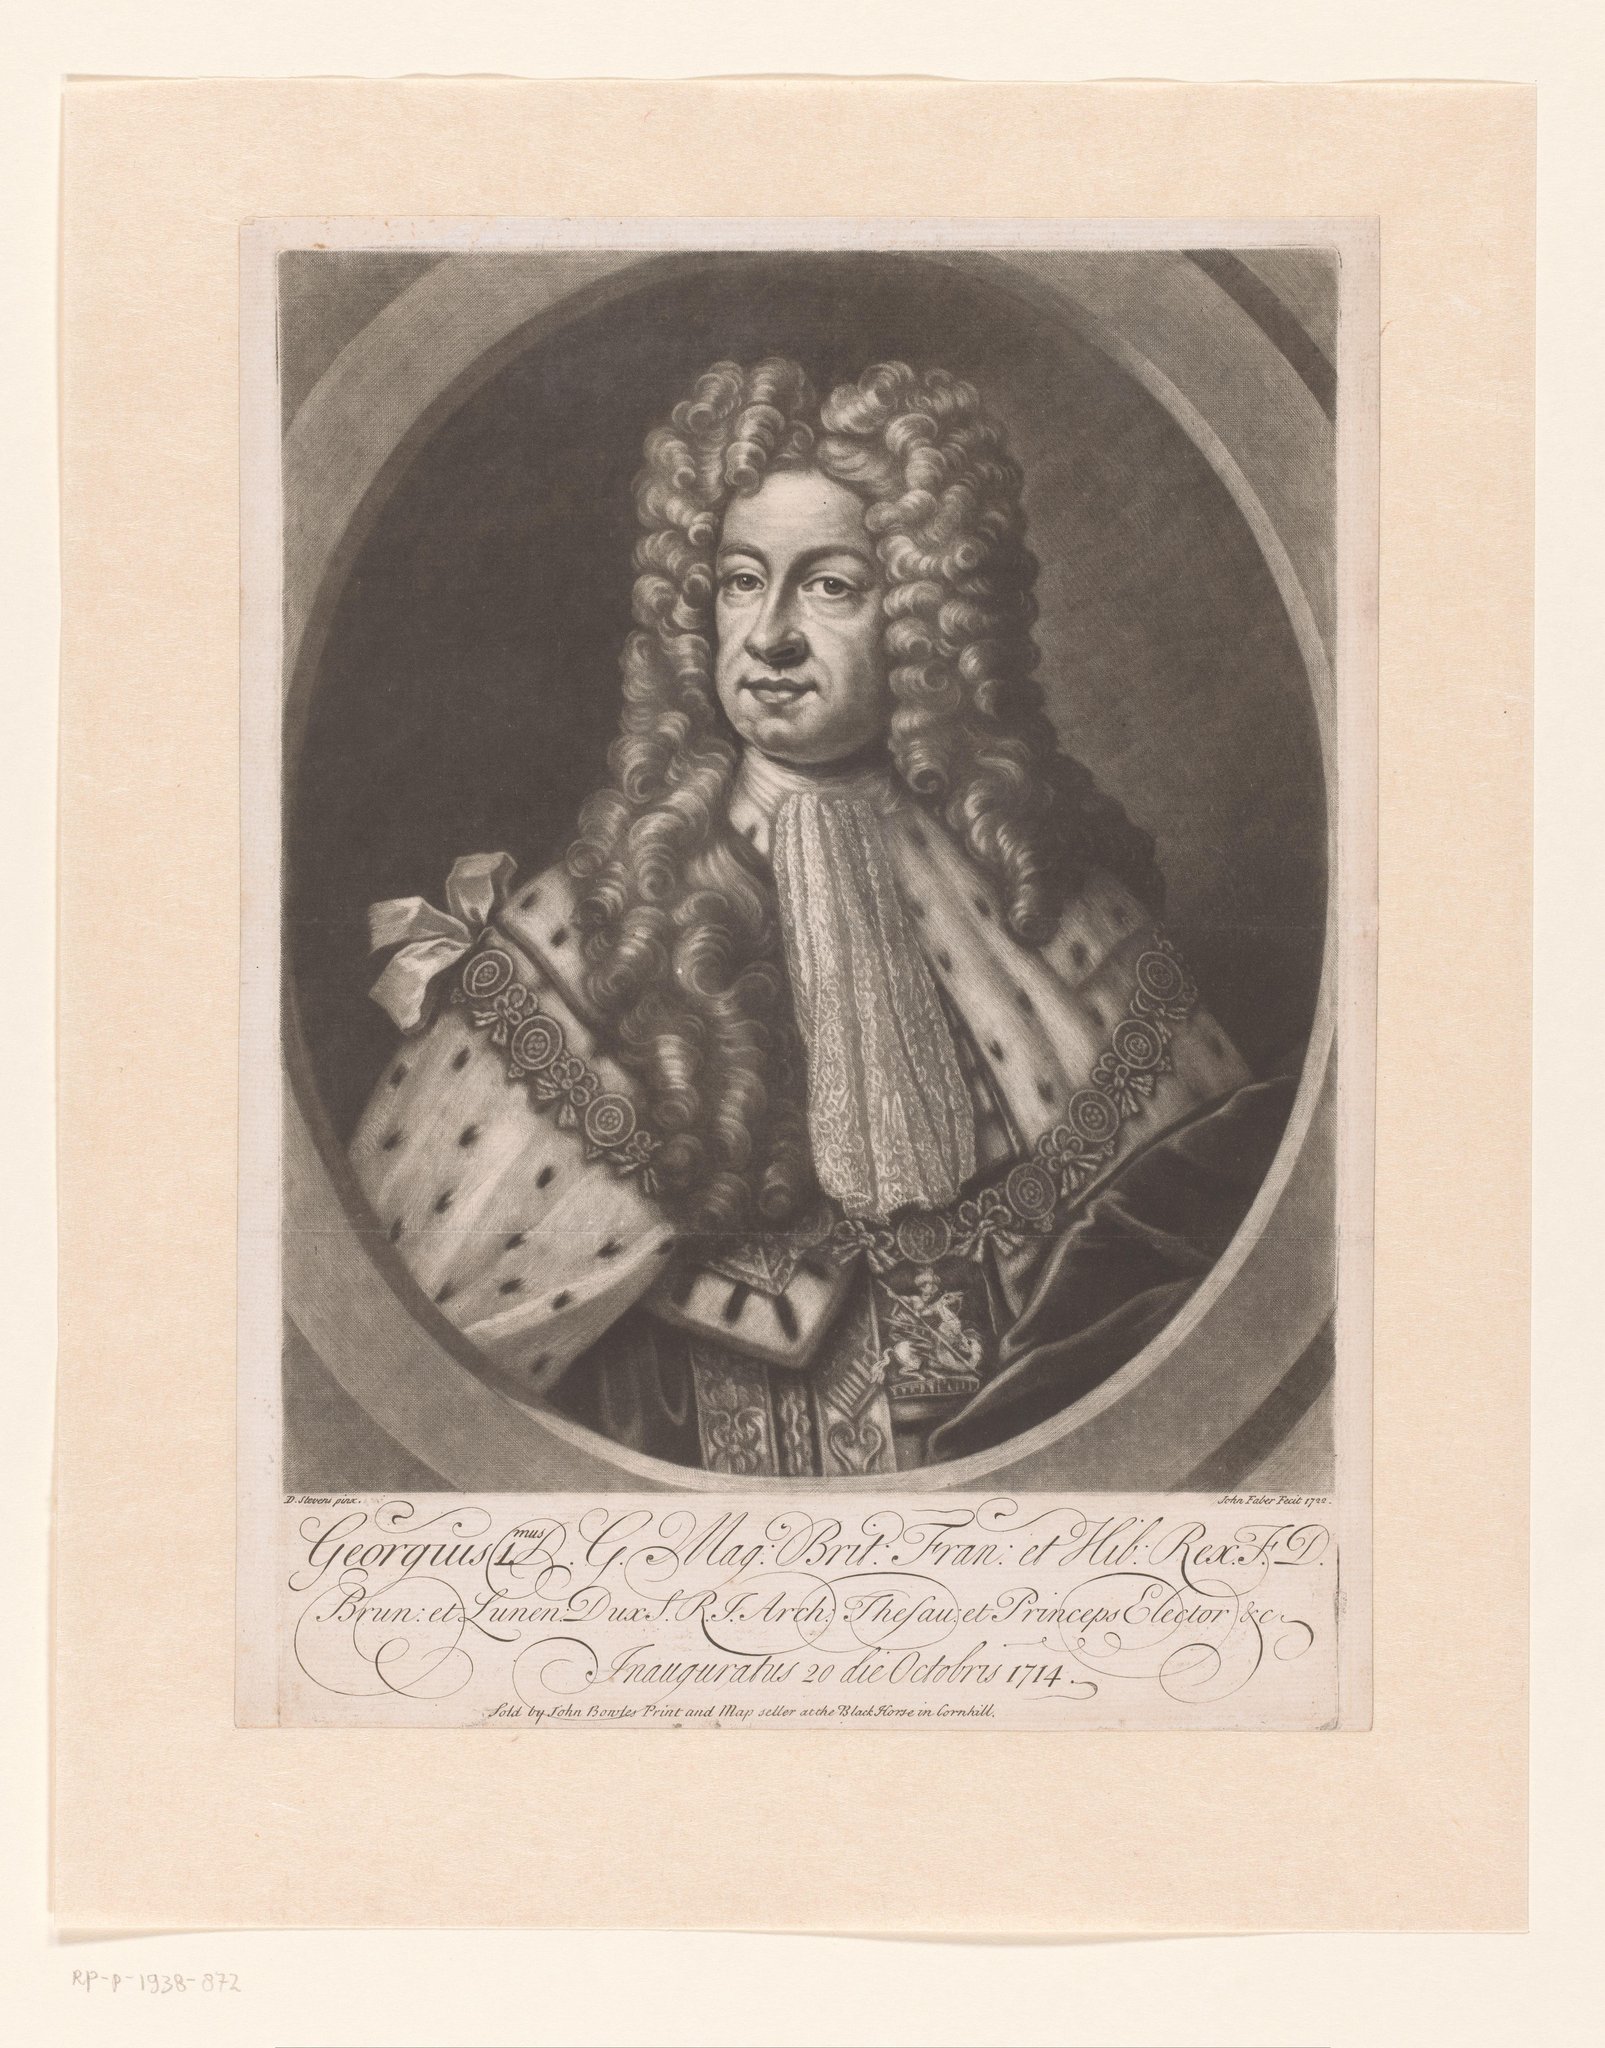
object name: print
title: Portret van George I, koning van Groot-Brittannië en Ierland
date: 1722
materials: paper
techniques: etching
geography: london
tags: george i (koning van groot-brittannië en ierland), historical persons, king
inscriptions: collector's mark: Lugt 2228, collector's mark: Lugt 2228